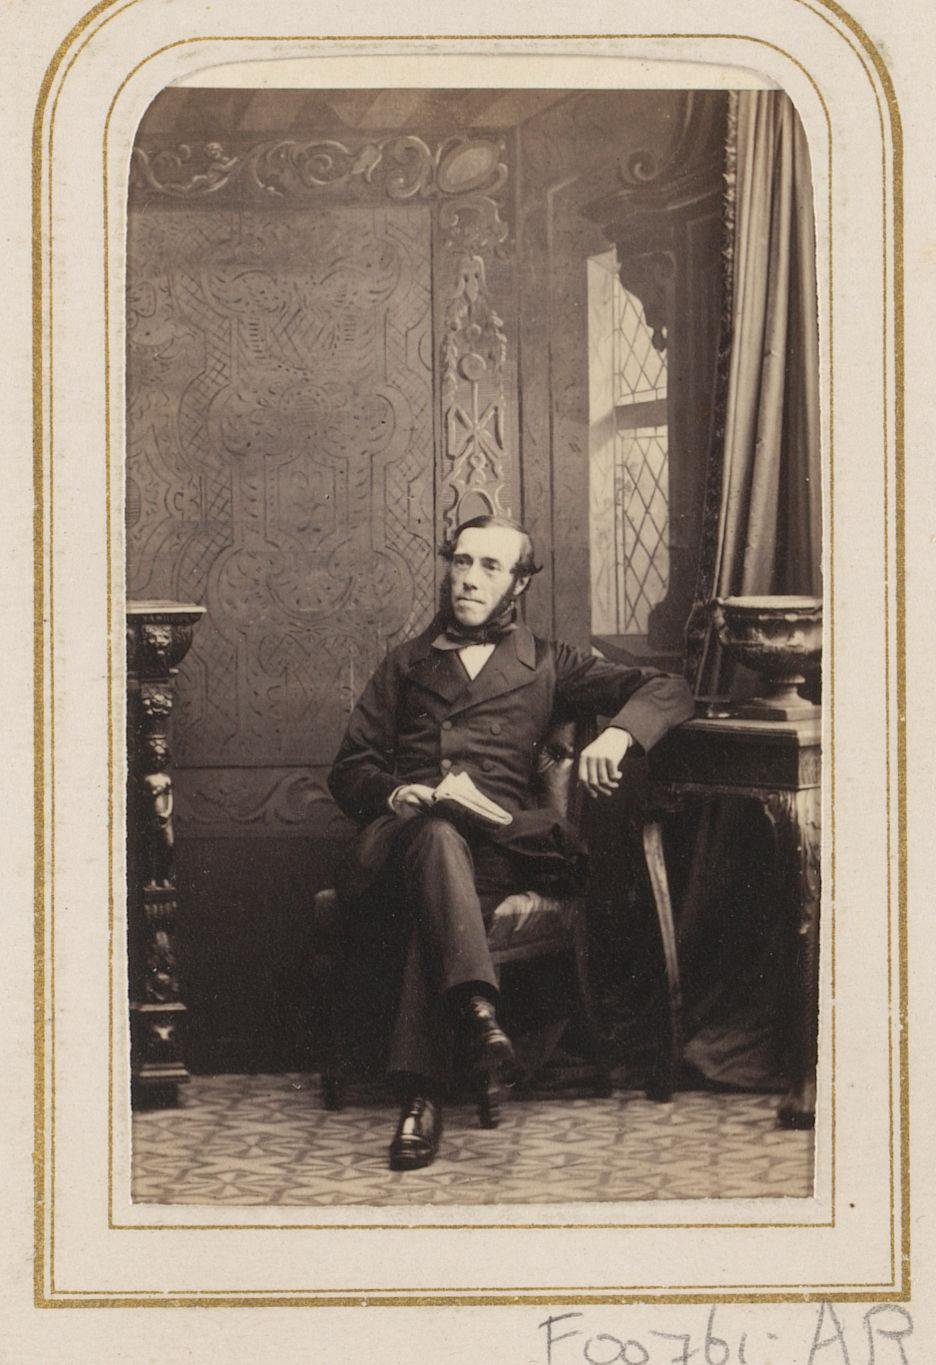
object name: photograph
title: Portret van een man met krant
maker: camille leon louis silvy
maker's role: fotograaf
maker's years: 1834-1910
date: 1859-1890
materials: cardboard, photographic support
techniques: albumen print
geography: london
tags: historical persons, newspaper, news-sheet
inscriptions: inscription: ‘Bayswater W., 38 Porchester Terrace’